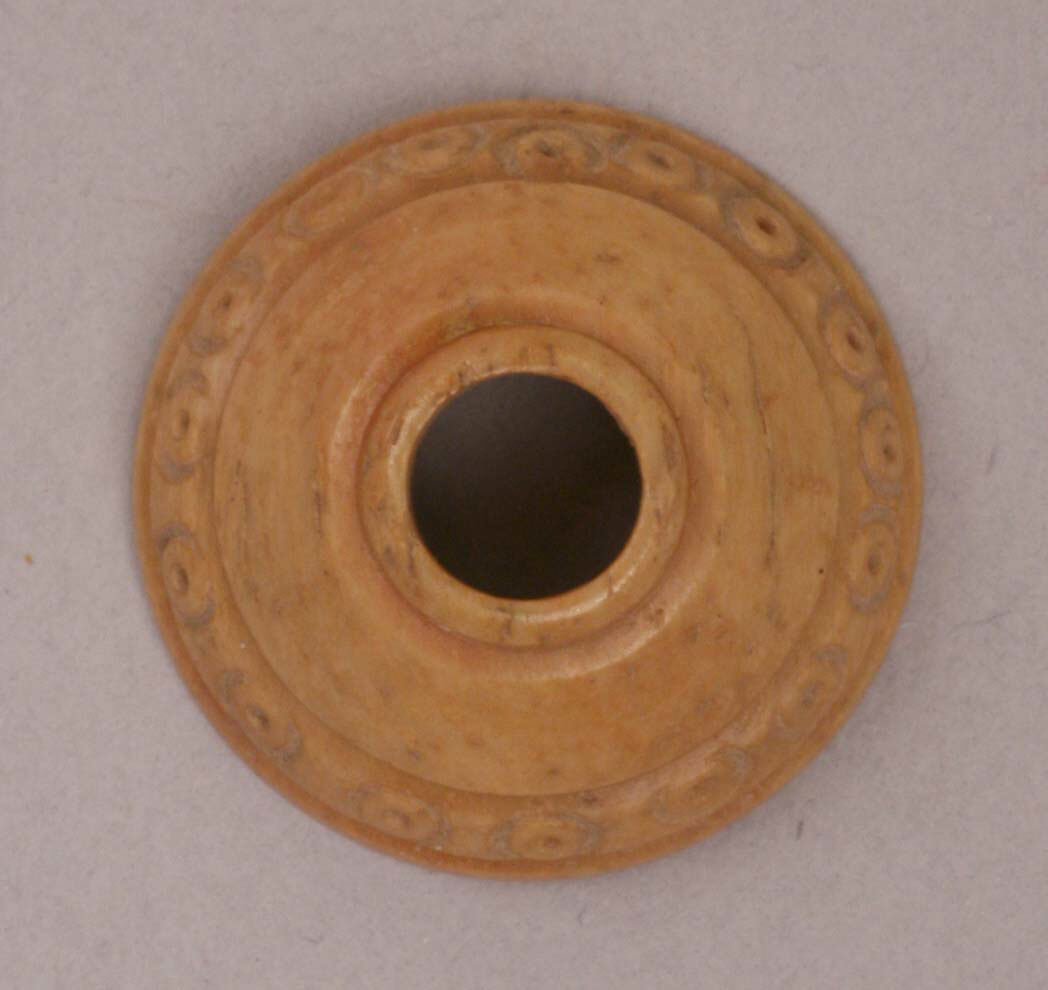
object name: button or bead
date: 801-1000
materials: bone, paint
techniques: incising, inlay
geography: iran